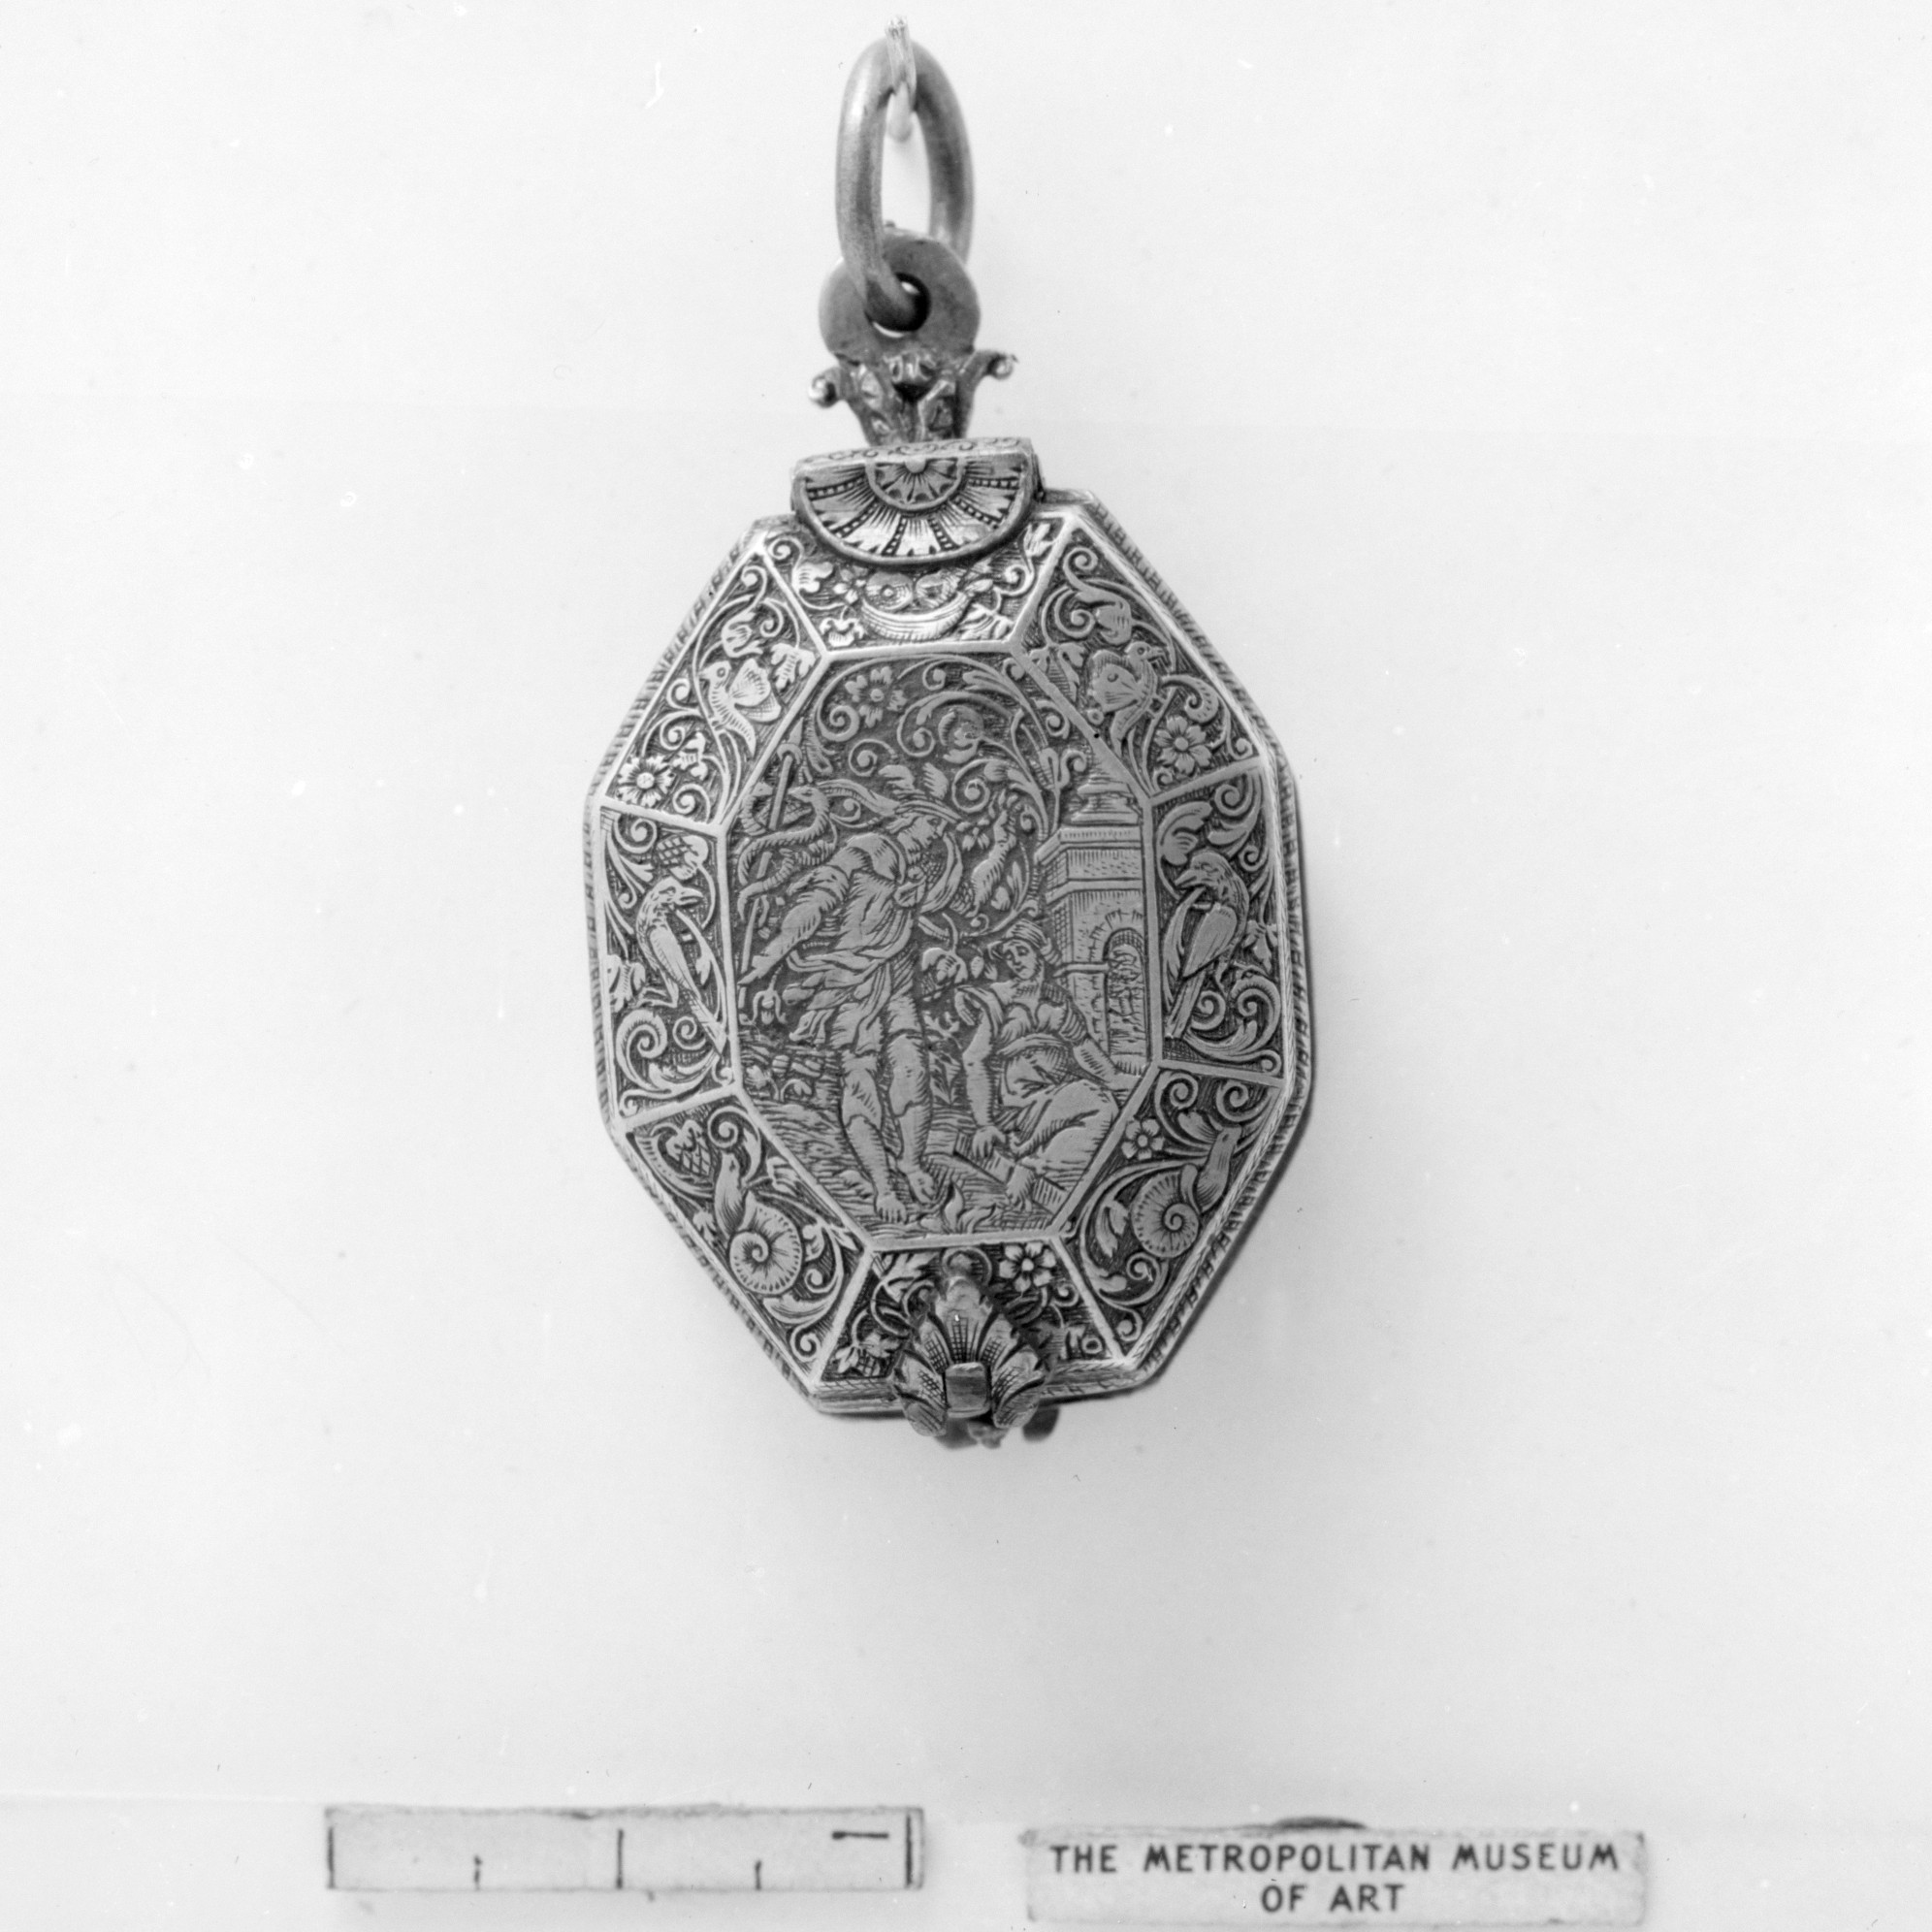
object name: watch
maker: conrad kreizer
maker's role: maker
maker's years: 1580-1640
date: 1601-1700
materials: silver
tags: birds,men,women